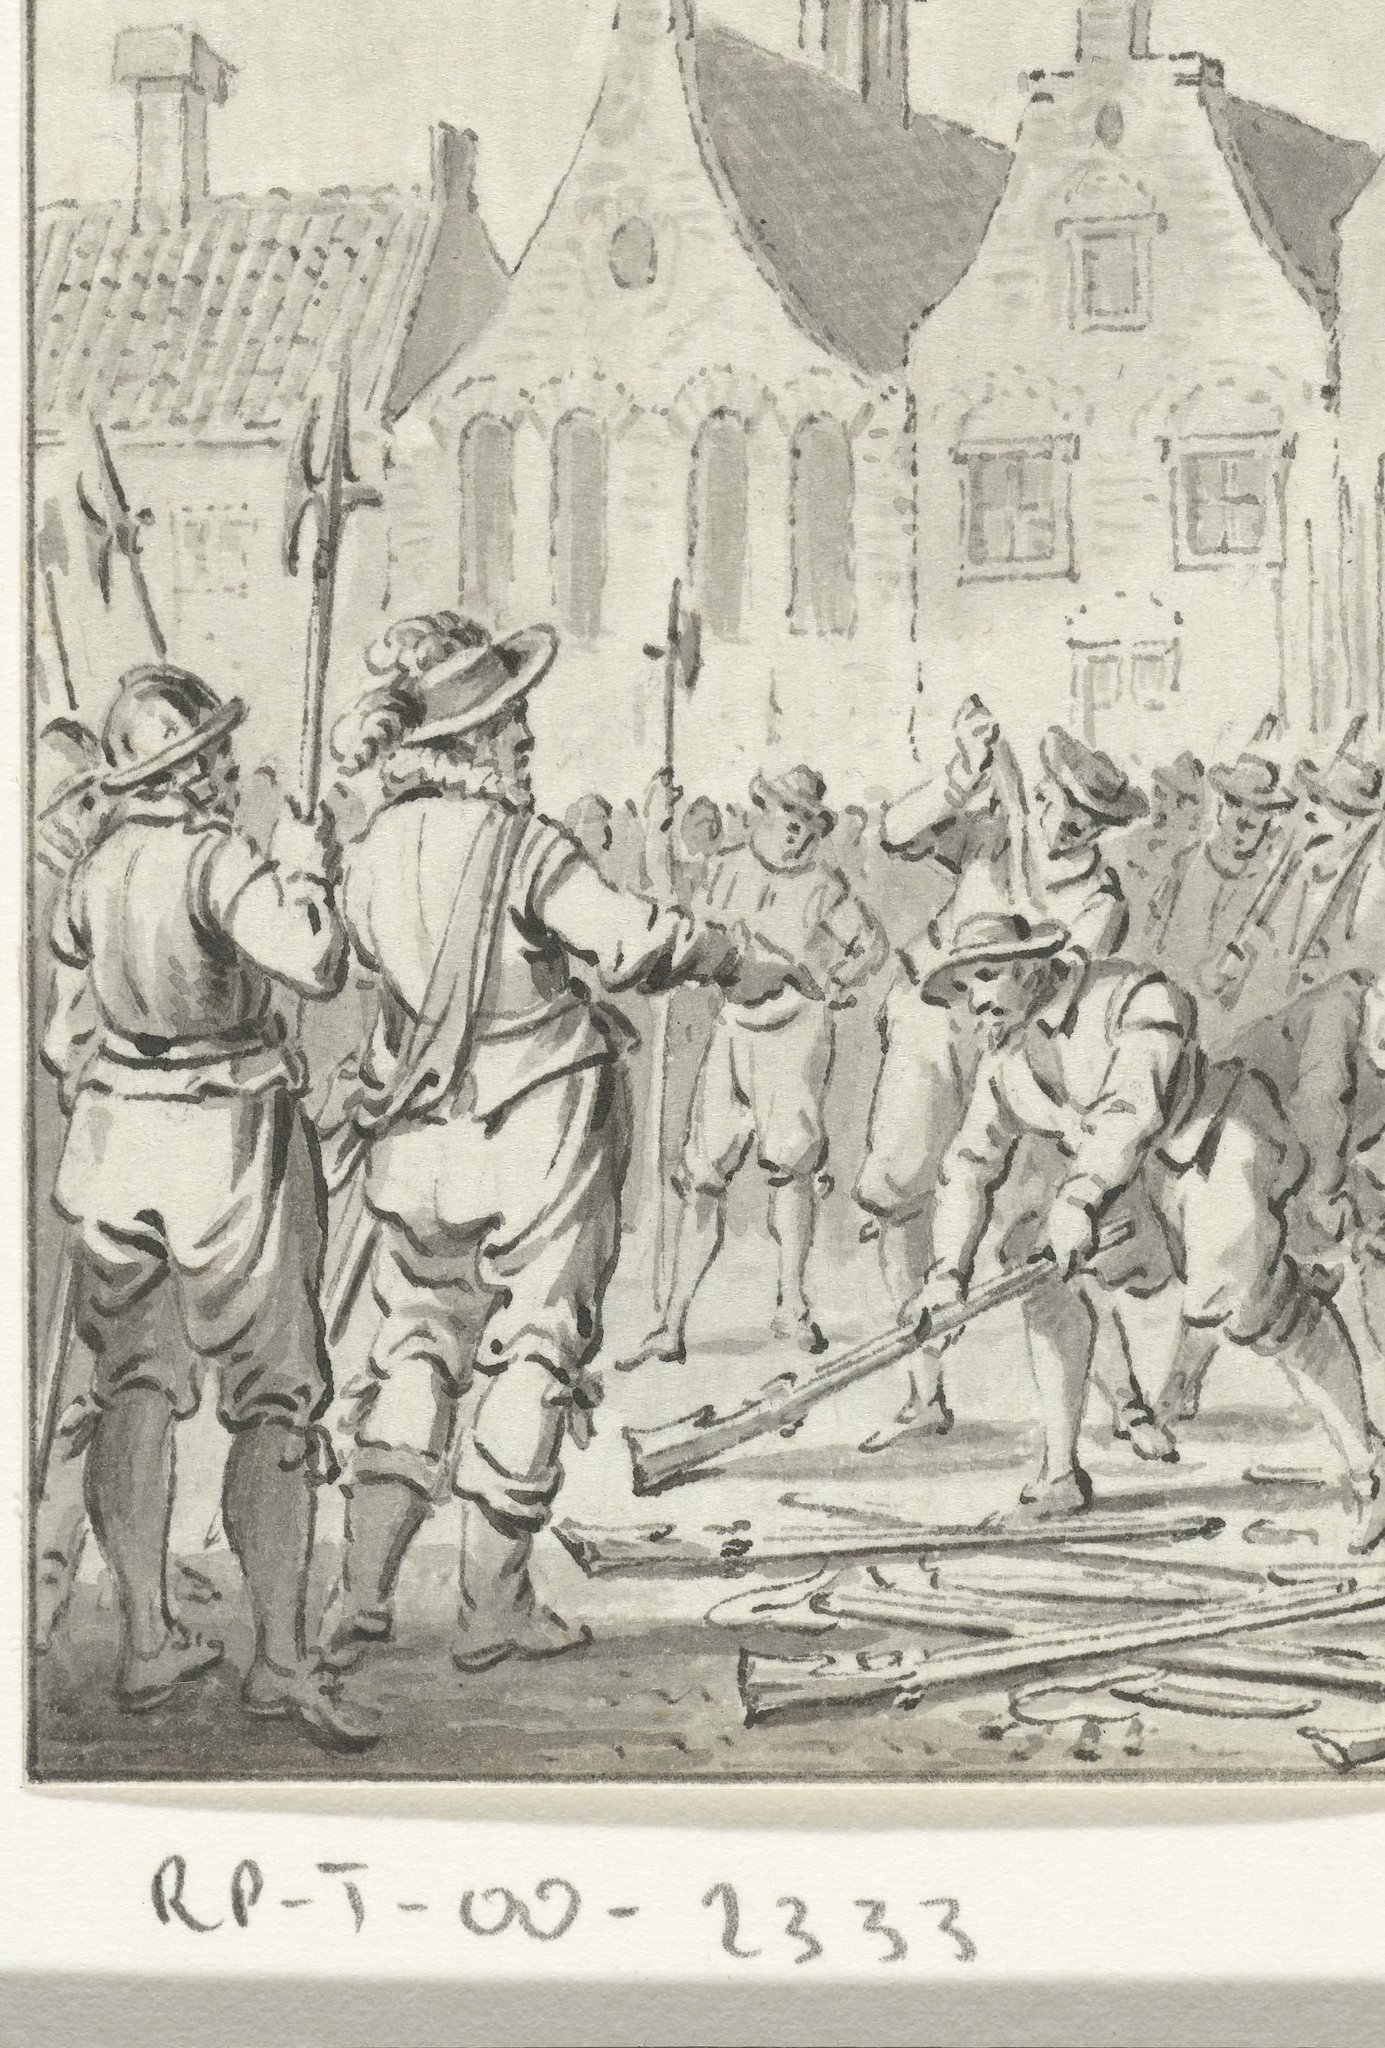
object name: drawing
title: Het afdanken van de Waardgelders te Utrecht, 1618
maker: jacobus buys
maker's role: draughtsman, print maker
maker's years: 1724-1801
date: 1780-1795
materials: ink, paper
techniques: brush, pen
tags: the hague, maurice (prince of orange), demobilization, land forces (+ mercenary troops, e.g.: lansquenets), disbanding of the troops, warfare; military affairs (+ mercenary troops, e.g.: lansquenets), assembling of military forces; mobilization, troop concentration, etc., historical events and situations, utrecht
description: De afdanking van de waardgelders op bevel van prins Maurits, op de Neude te Utrecht, 31 juli 1618. De soldaten leggen hun wapens op de grond aan de voeten van prins Maurits. Ontwerp voor een prent.